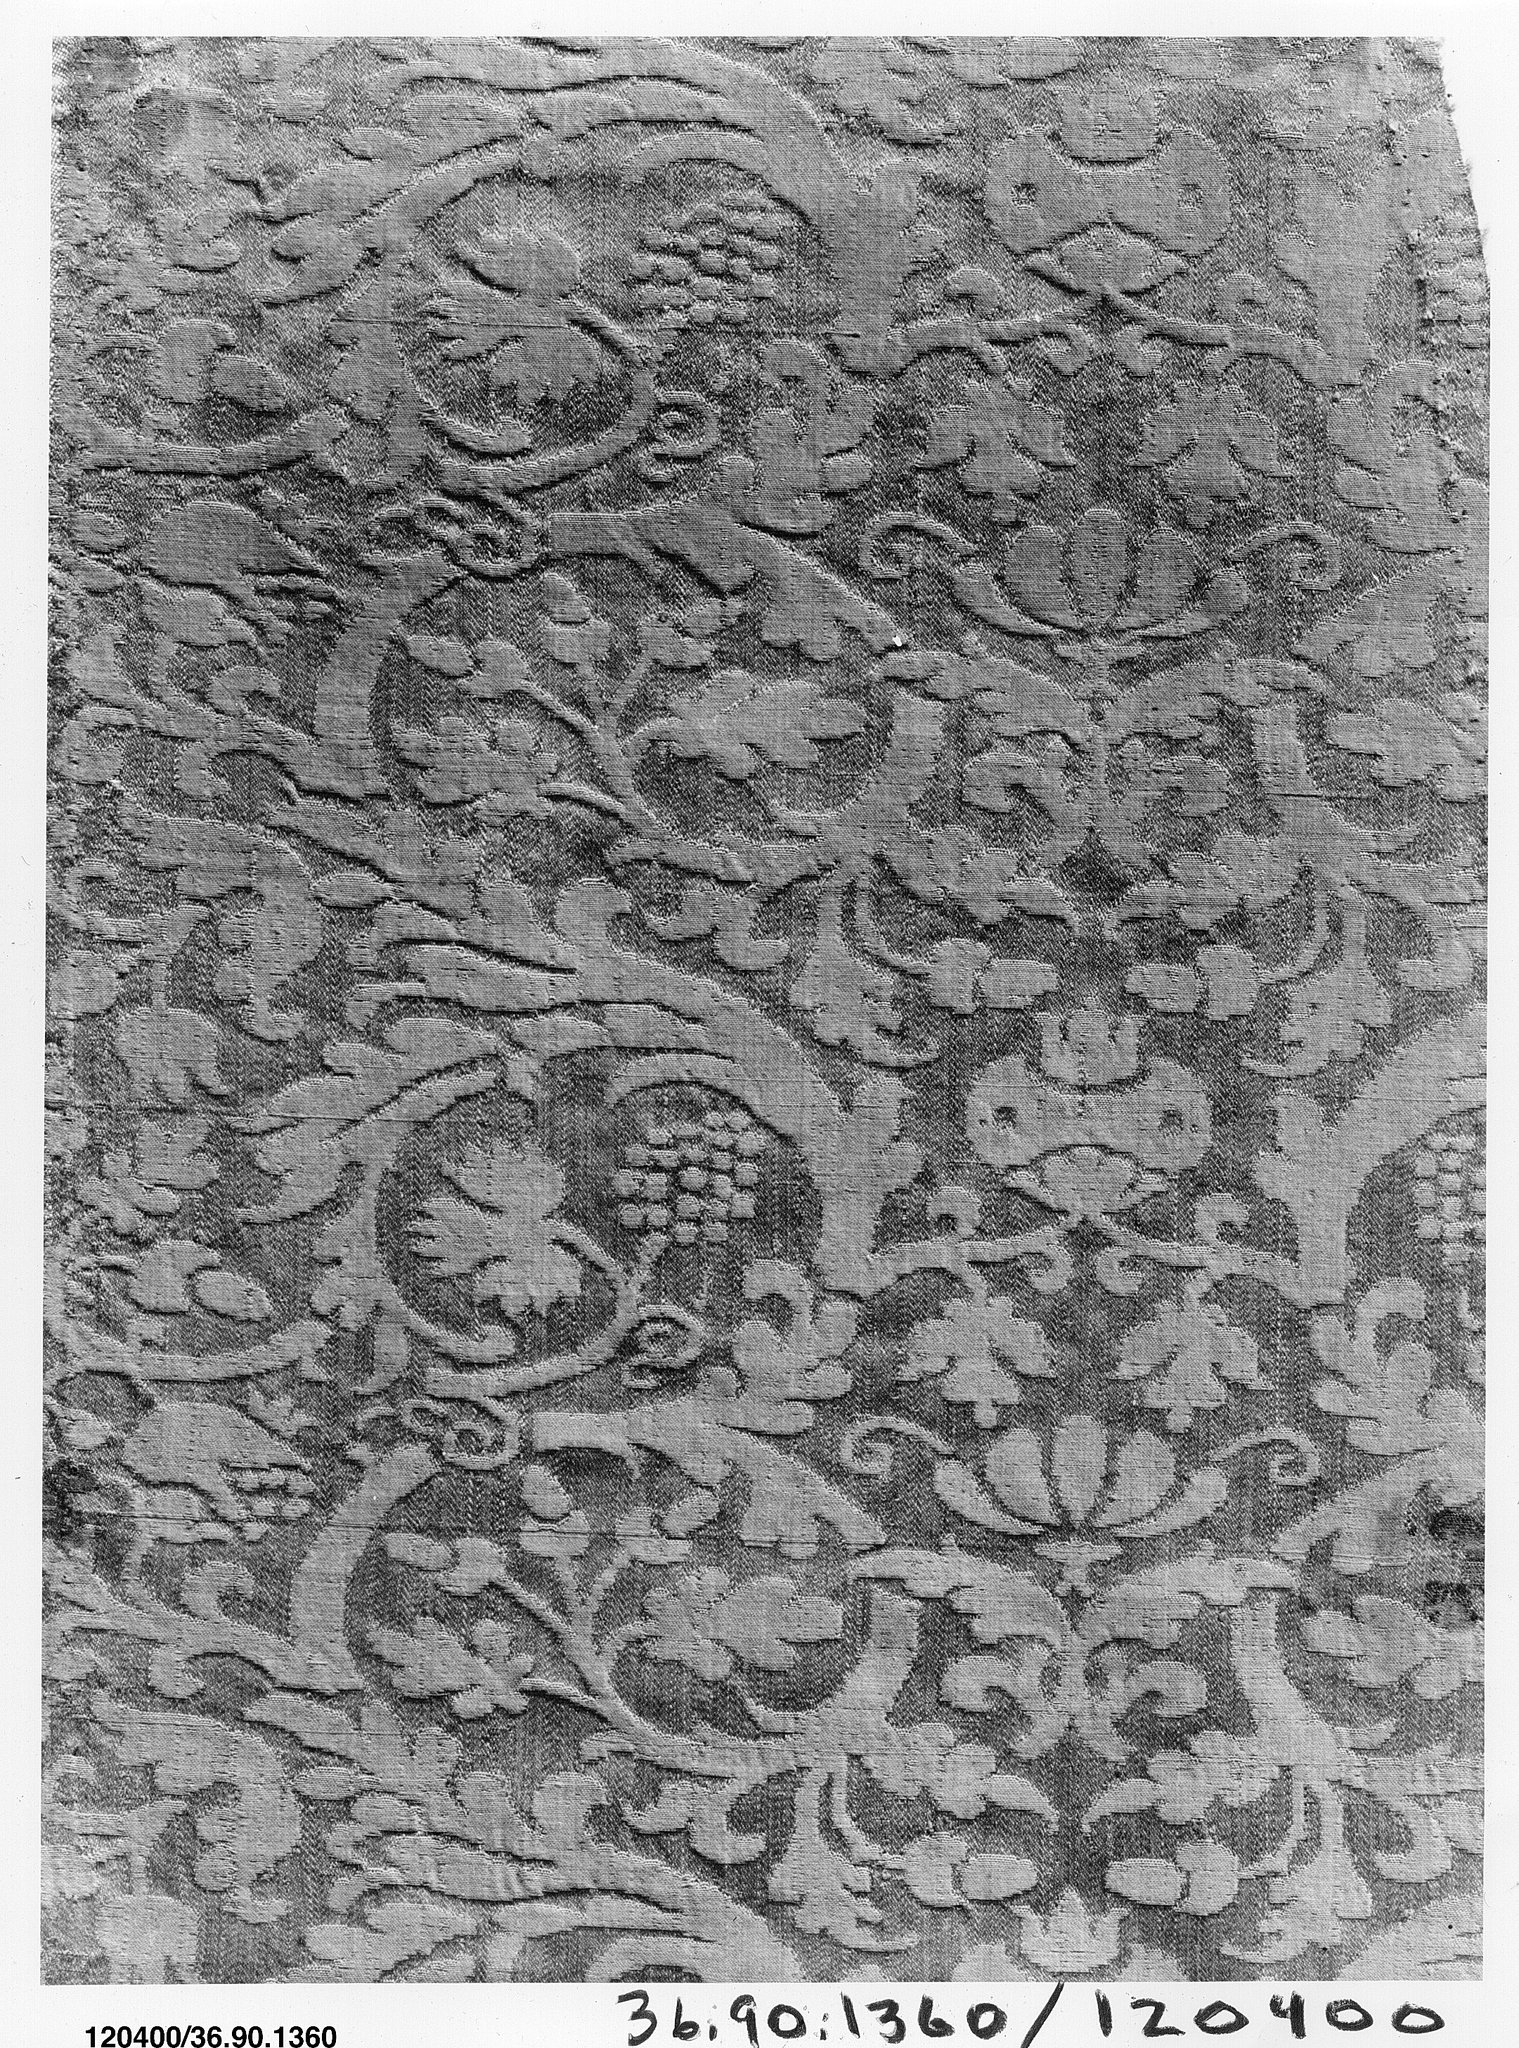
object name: piece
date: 1650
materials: silk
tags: flowers,leaves